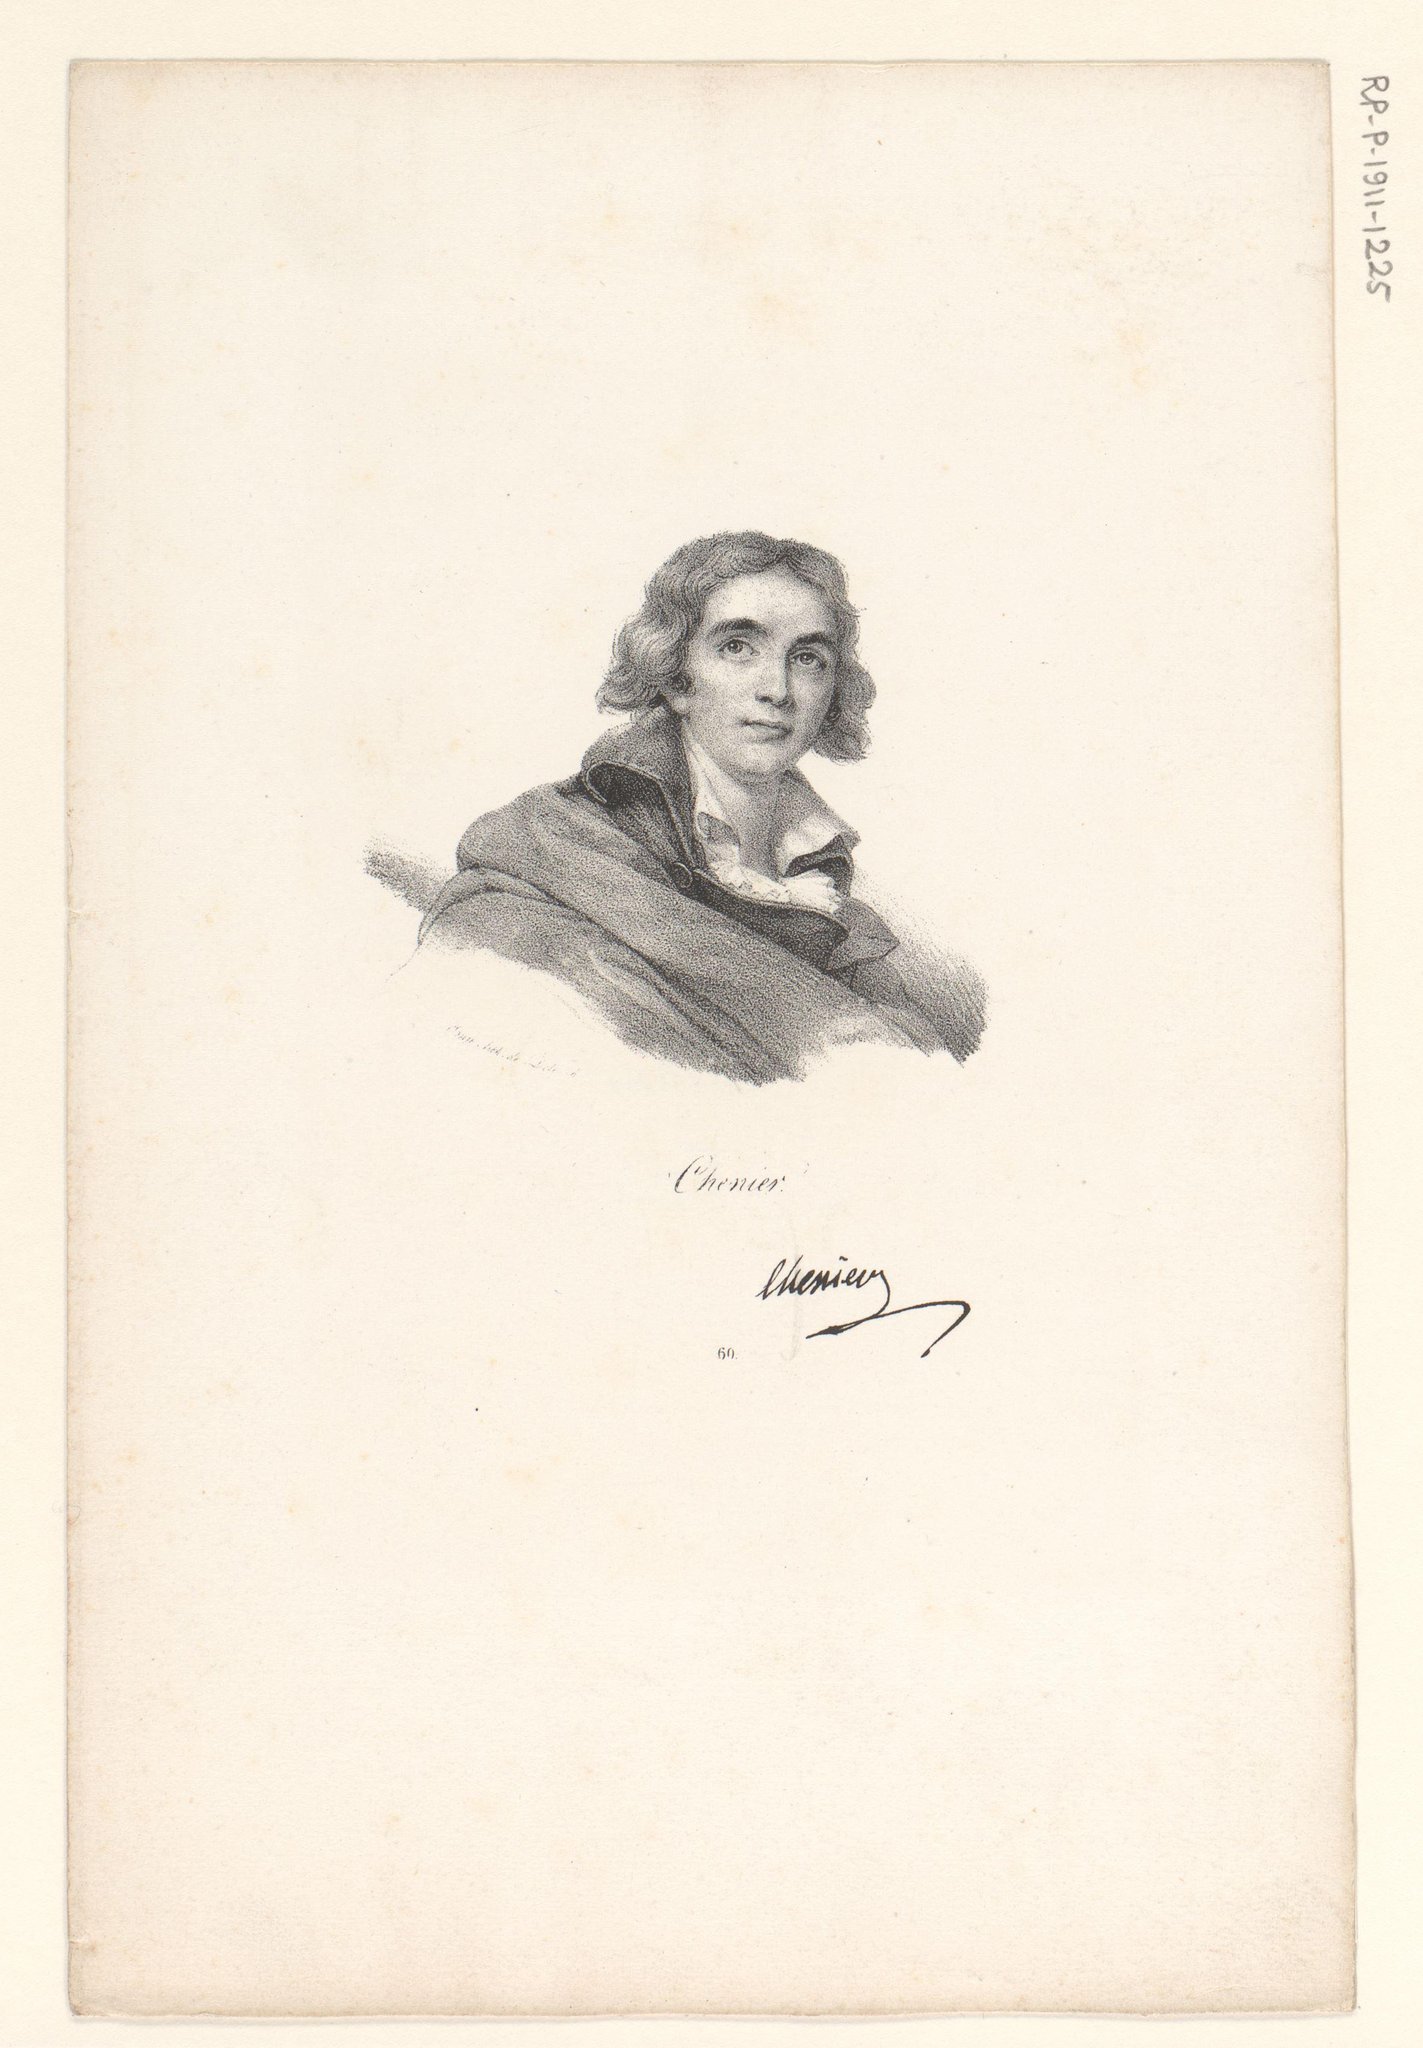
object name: print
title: Chenier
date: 1818-1842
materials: paper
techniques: lithograph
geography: paris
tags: politician, historical persons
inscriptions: collector's mark: Lugt 2228a